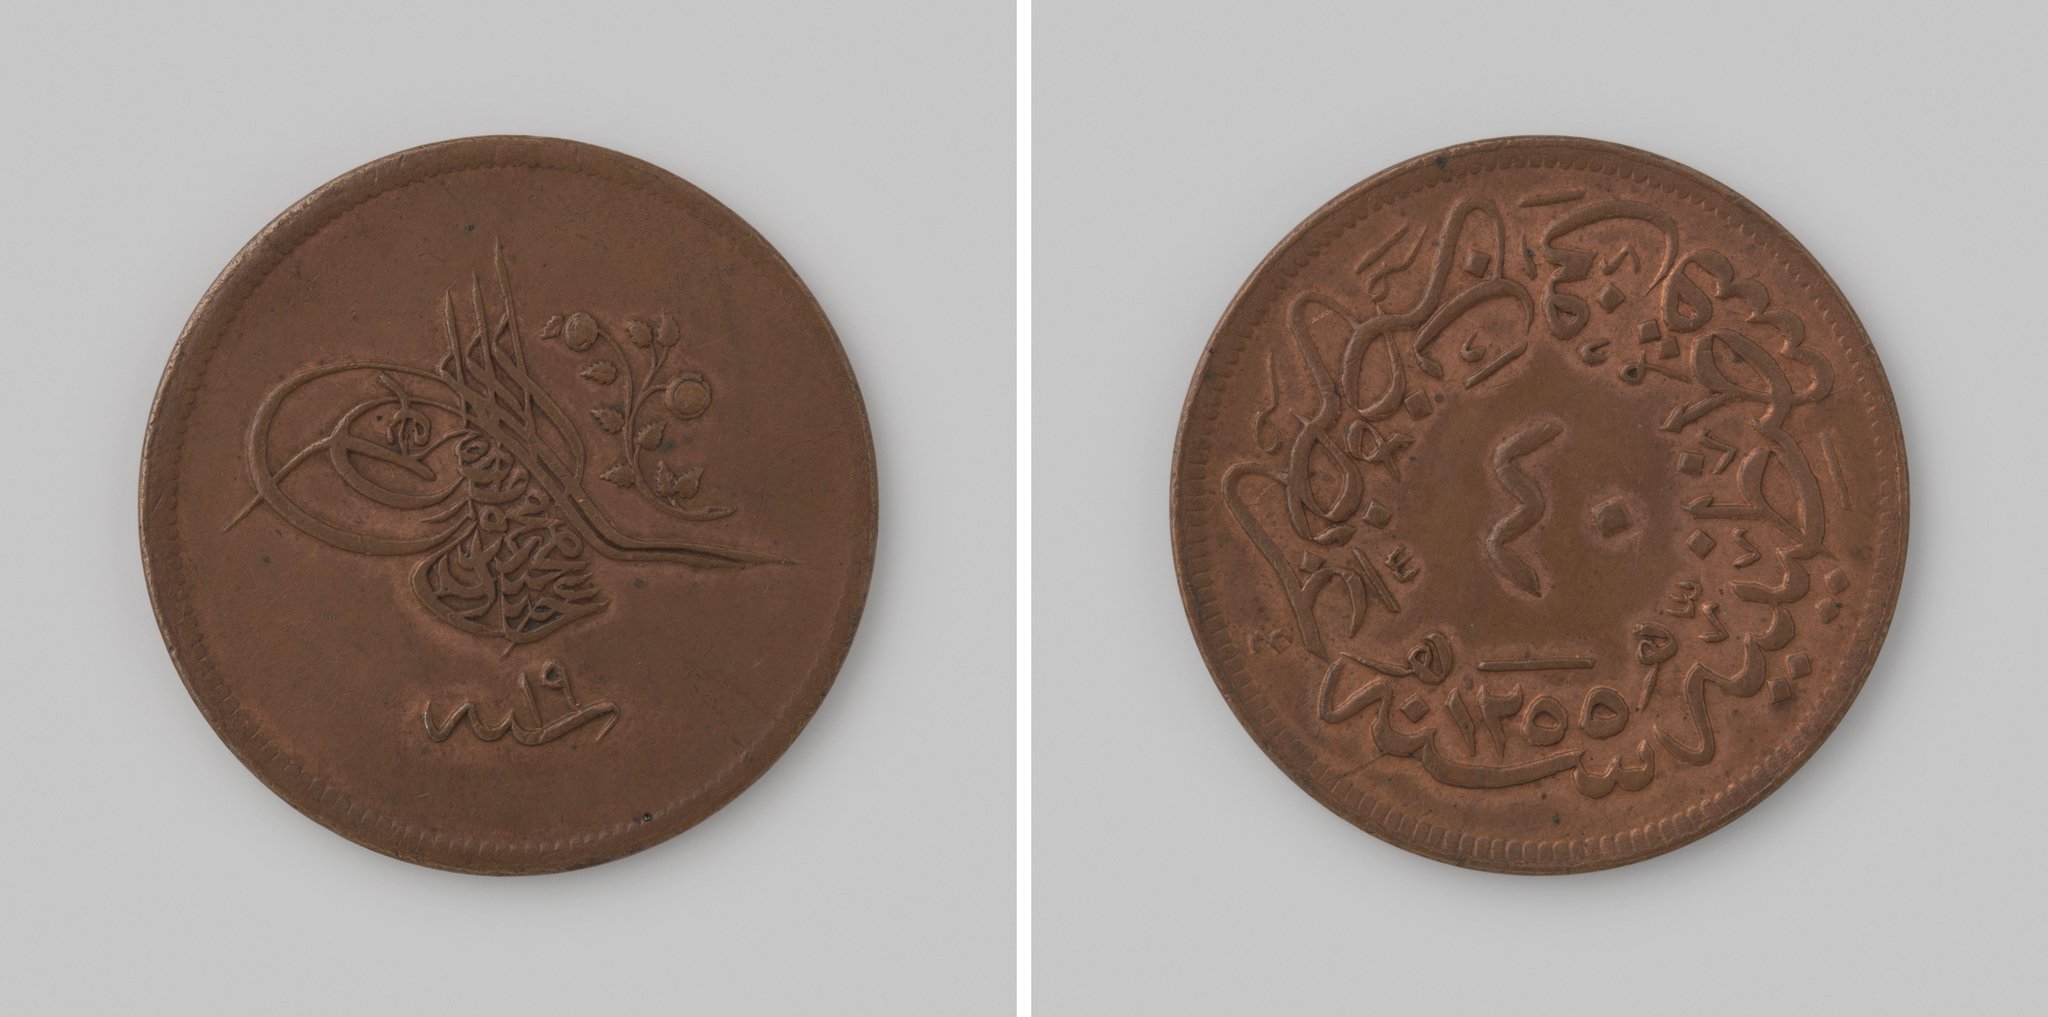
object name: coin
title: 40 para uit Turkije van sultan Abdul Medjid, regeringsjaar 19 [=1857]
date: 1857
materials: copper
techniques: striking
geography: constantinople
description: Koperen munt. Voorzijde: tughra met rechts daarvan takje met bladeren. Onder tughra regeringsjaar-aanduiding:19. Keerzijde: binnen omschrift in Arabische letters waarde-aanduiding: 40. In omschrift muntplaats-aanduiding: Constantinopel en aanduiding jaar van aantreden: 1255 [=1839].